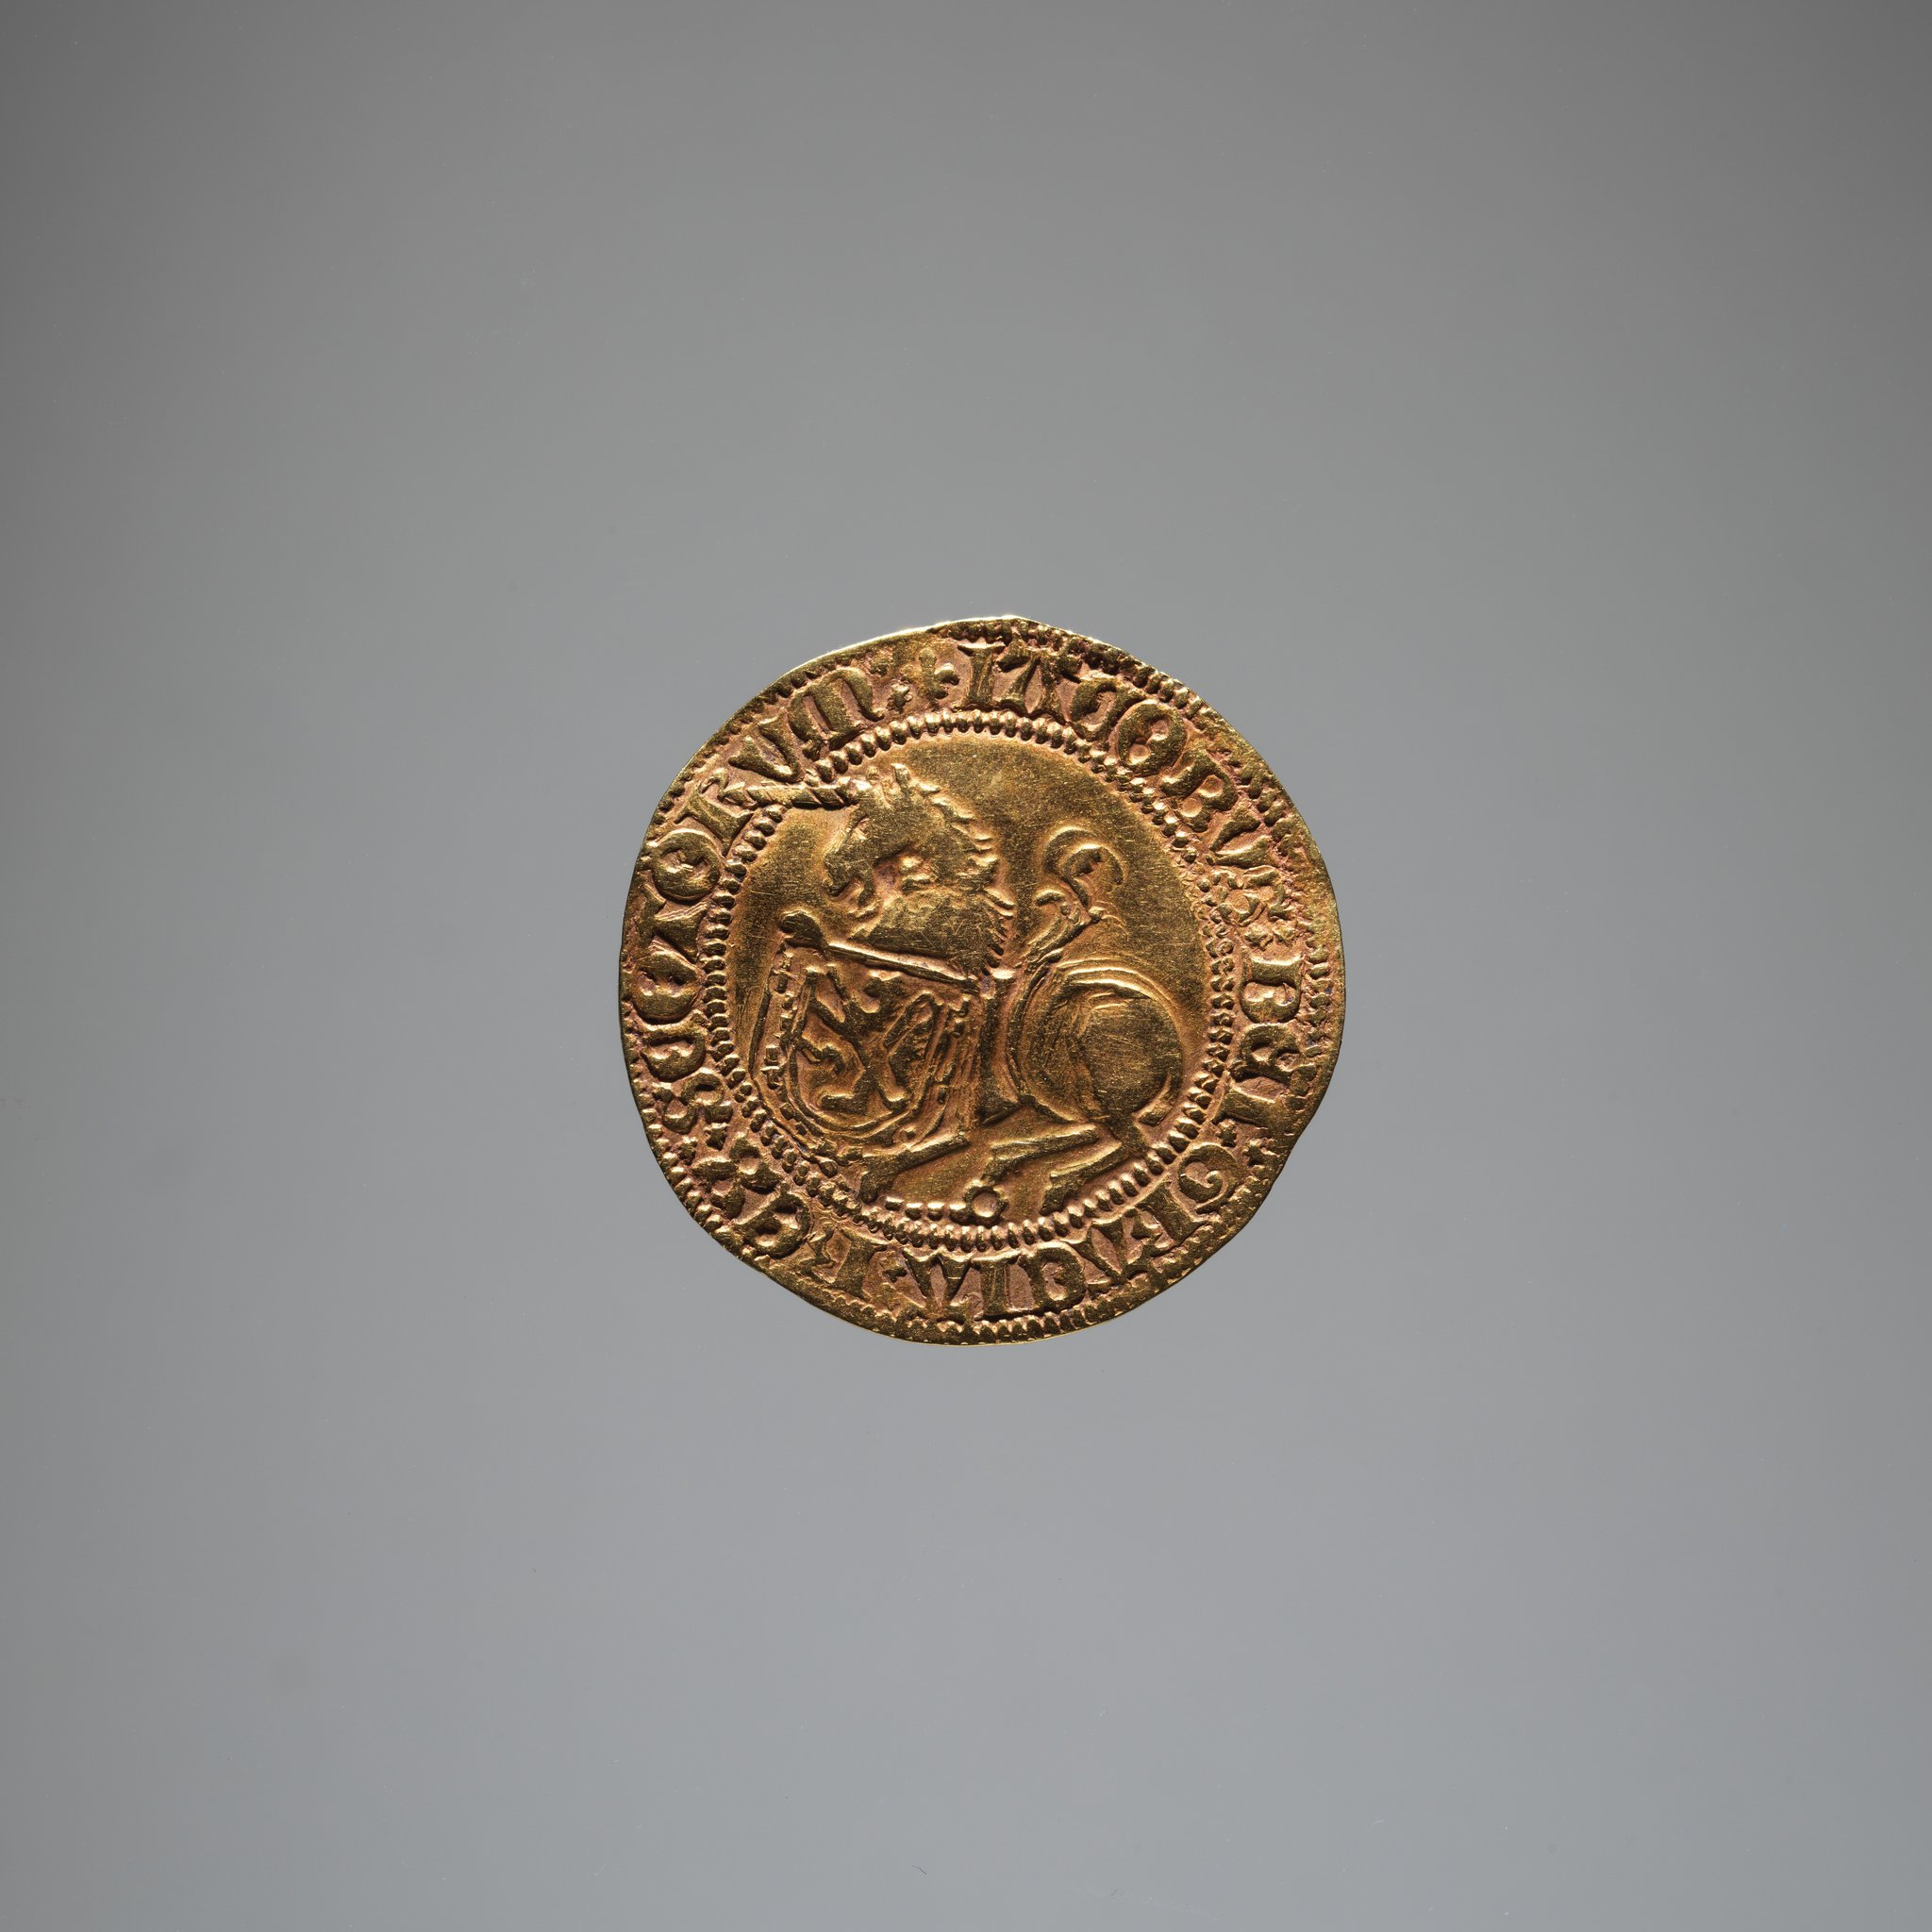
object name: unicorn coin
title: Unicorn of James IV of Scotland (r. 1488–1513)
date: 1488-1513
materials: gold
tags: unicorns